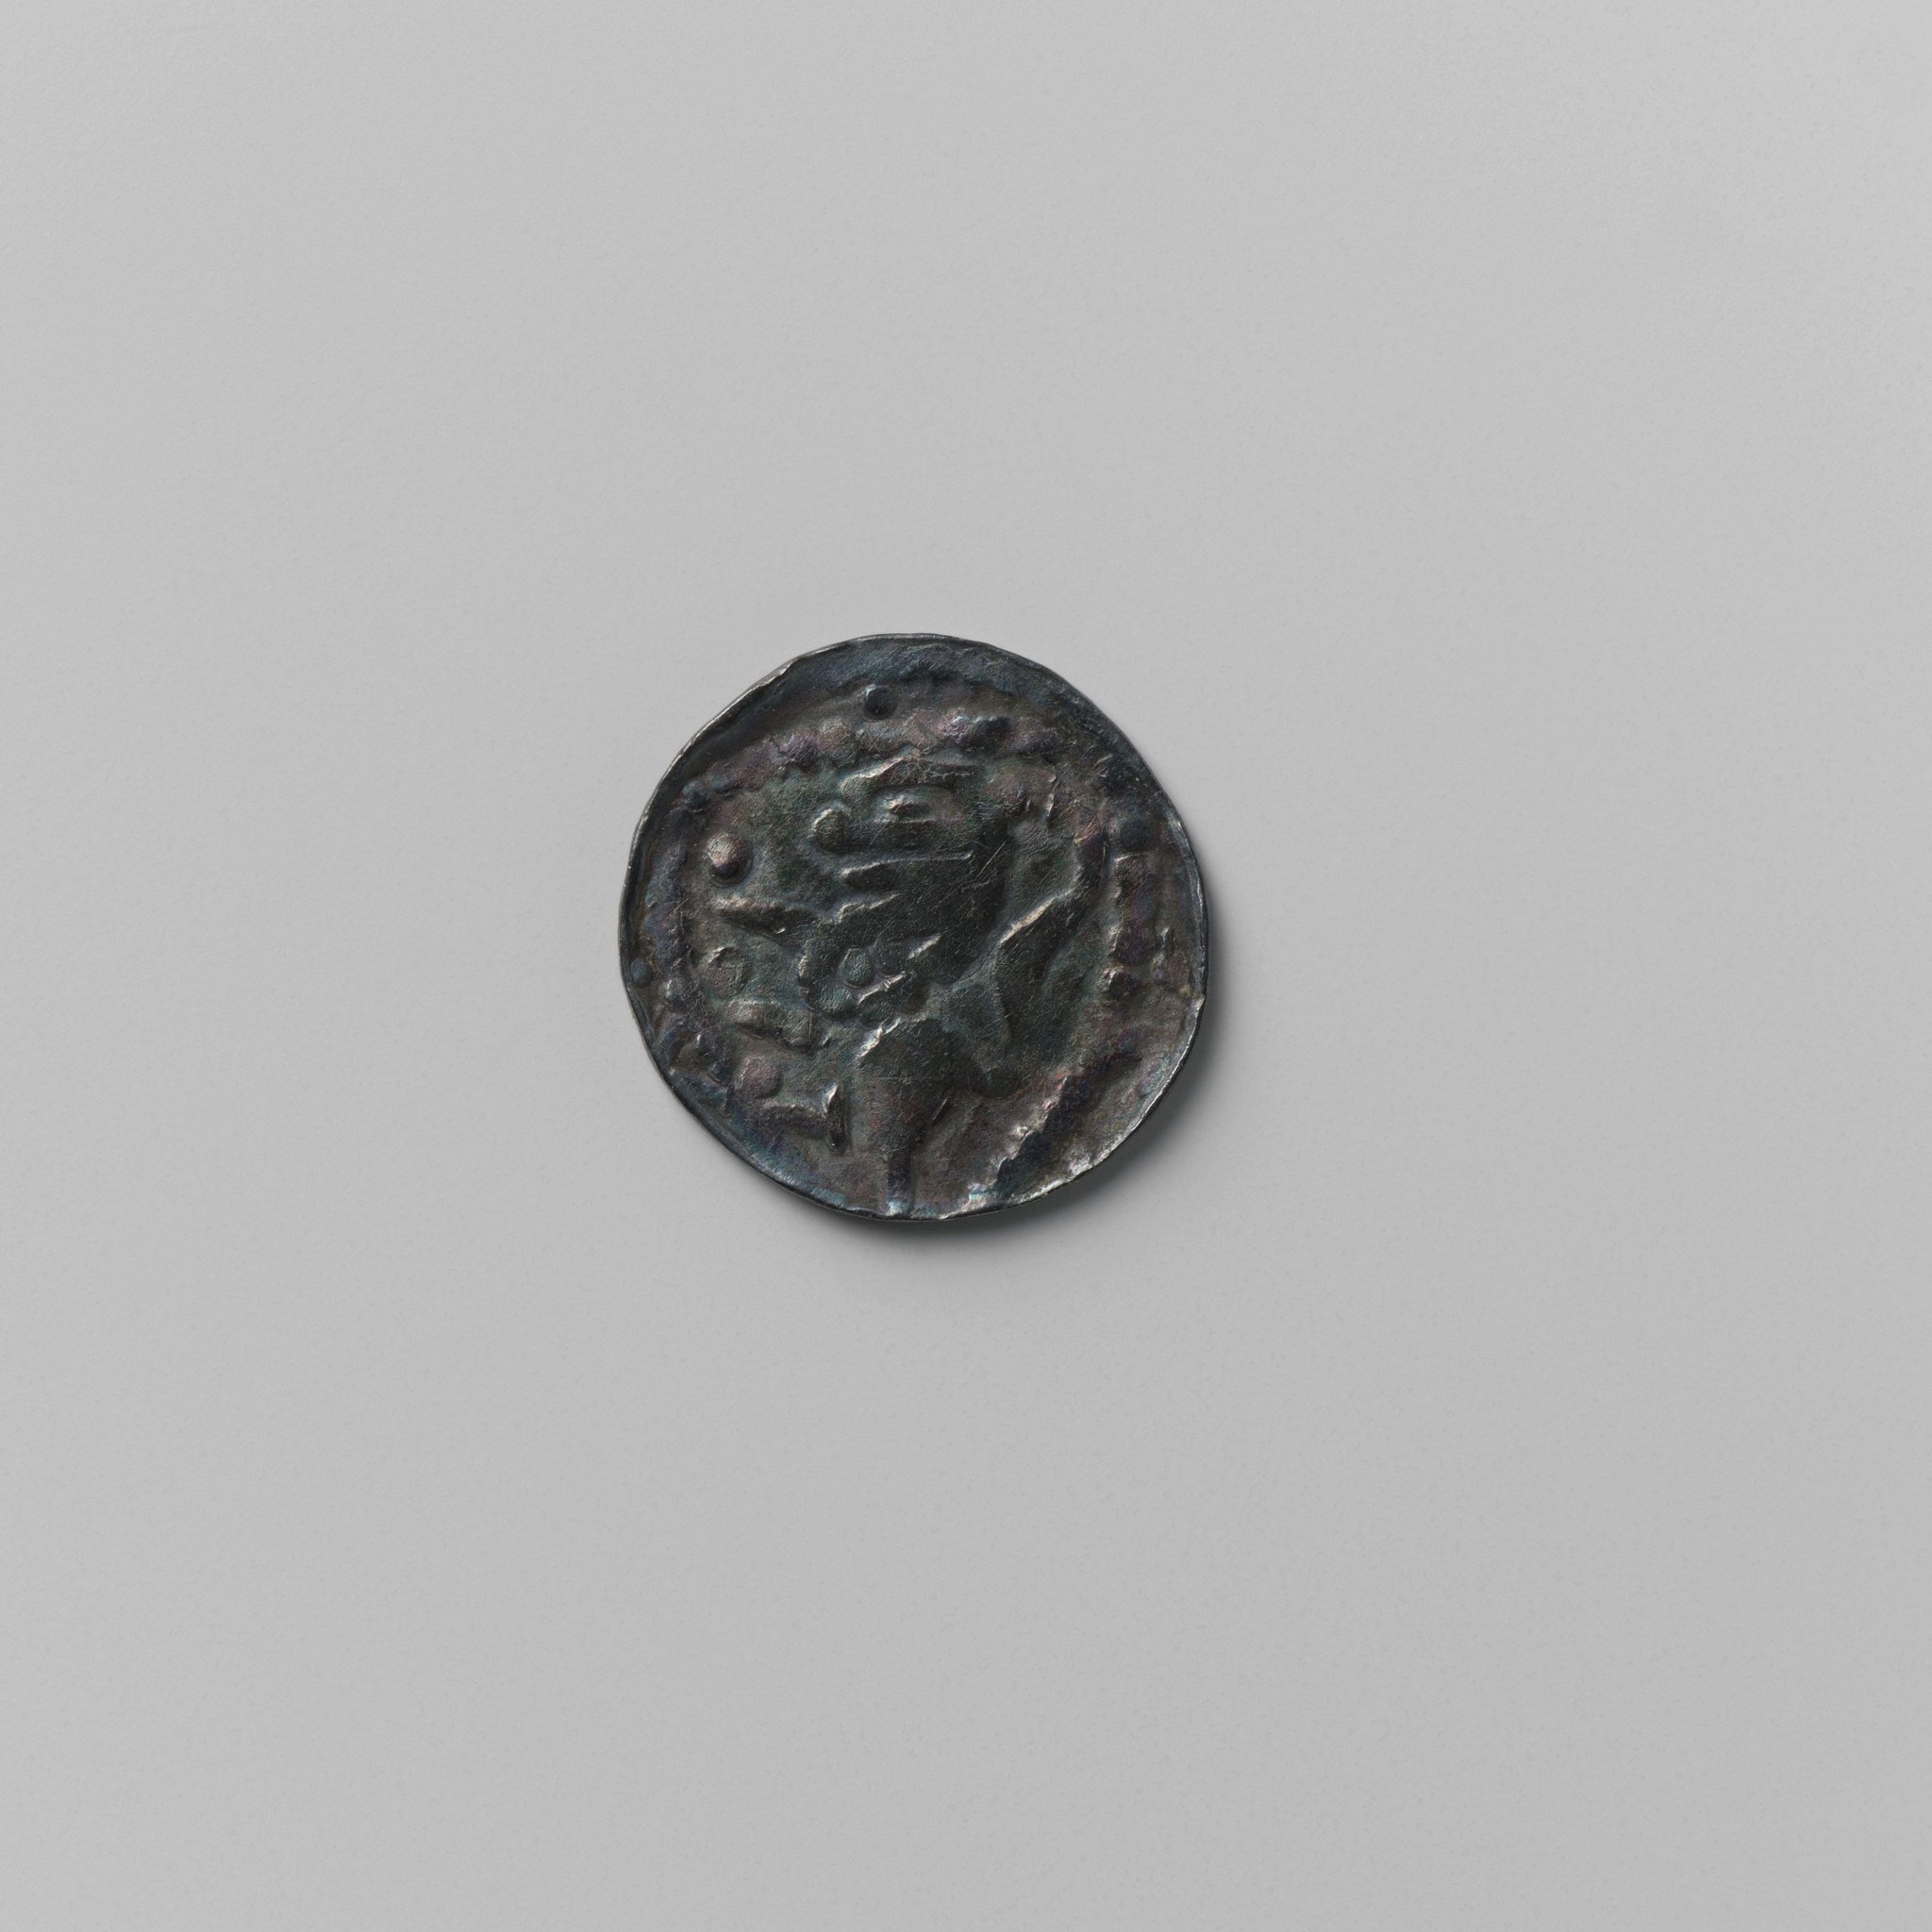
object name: coin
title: Penning uit Brabant van voogdes Aleida van Bourgondië, 1261-1267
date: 1261-1267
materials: silver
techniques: striking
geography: tienen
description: Voorzijde: in een punt uitlopend wapenschild met leeuw. Daaromheen letters V en N. Keerzijde: versierd kruis, in de hoeken letters.